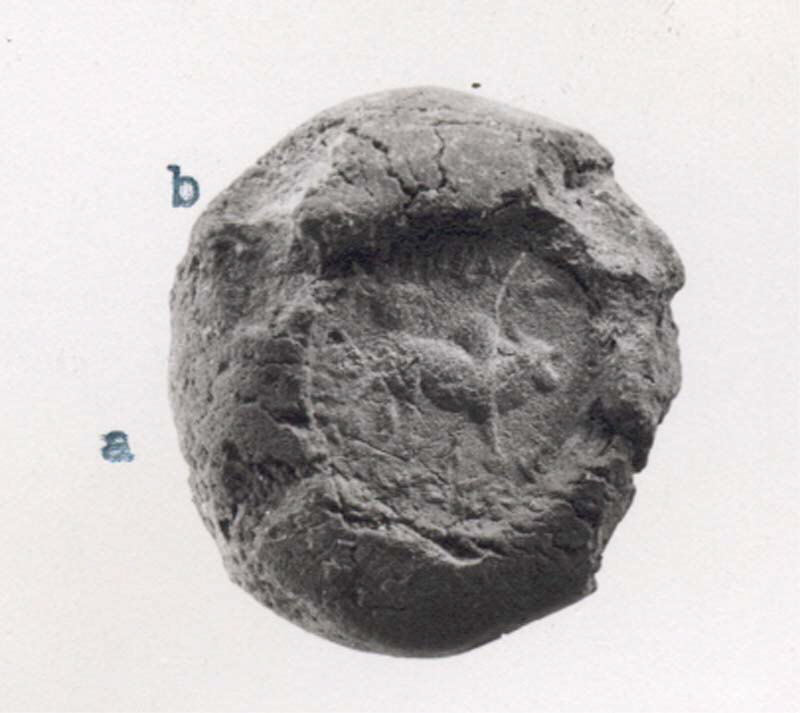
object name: sealing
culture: sasanian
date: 601-700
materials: clay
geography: iran